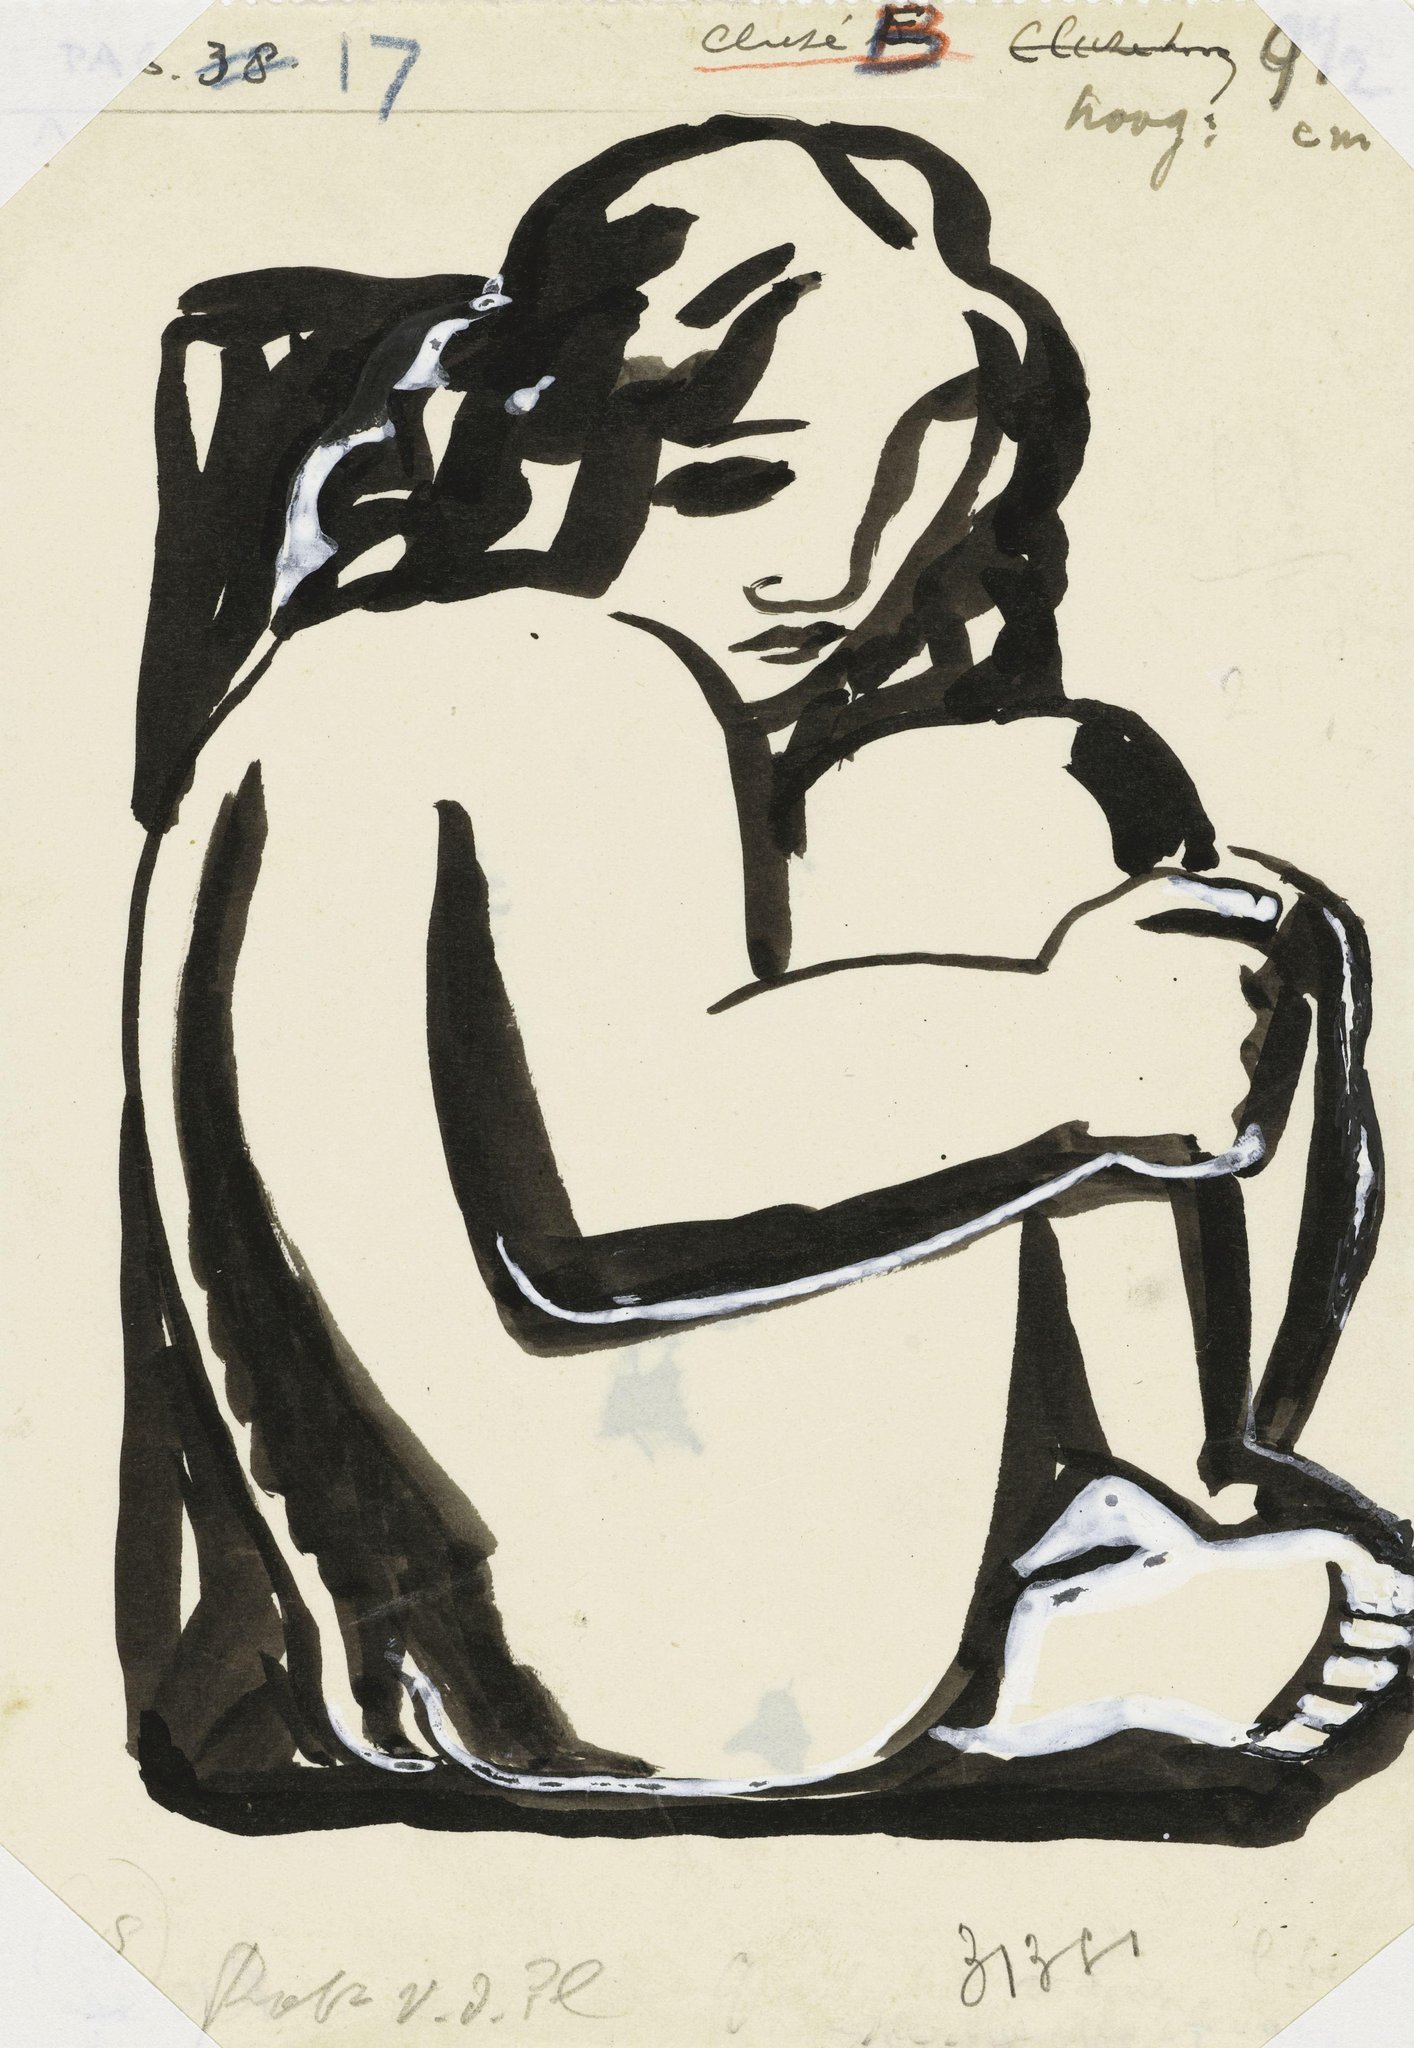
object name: drawing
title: Naakte zittende vrouw met opgetrokken knieën (schets)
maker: leo gestel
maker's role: draughtsman, print maker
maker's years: 1881-1941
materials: gouache, ink, paper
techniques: brush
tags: sitting figure - aa - female human figure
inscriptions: inscription: ‘prof v.d. Pl.’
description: Naakte zittende vrouw met opgetrokken knieën, de amandelvormige ogen met zwart ingevuld, enige witte hoogsels.